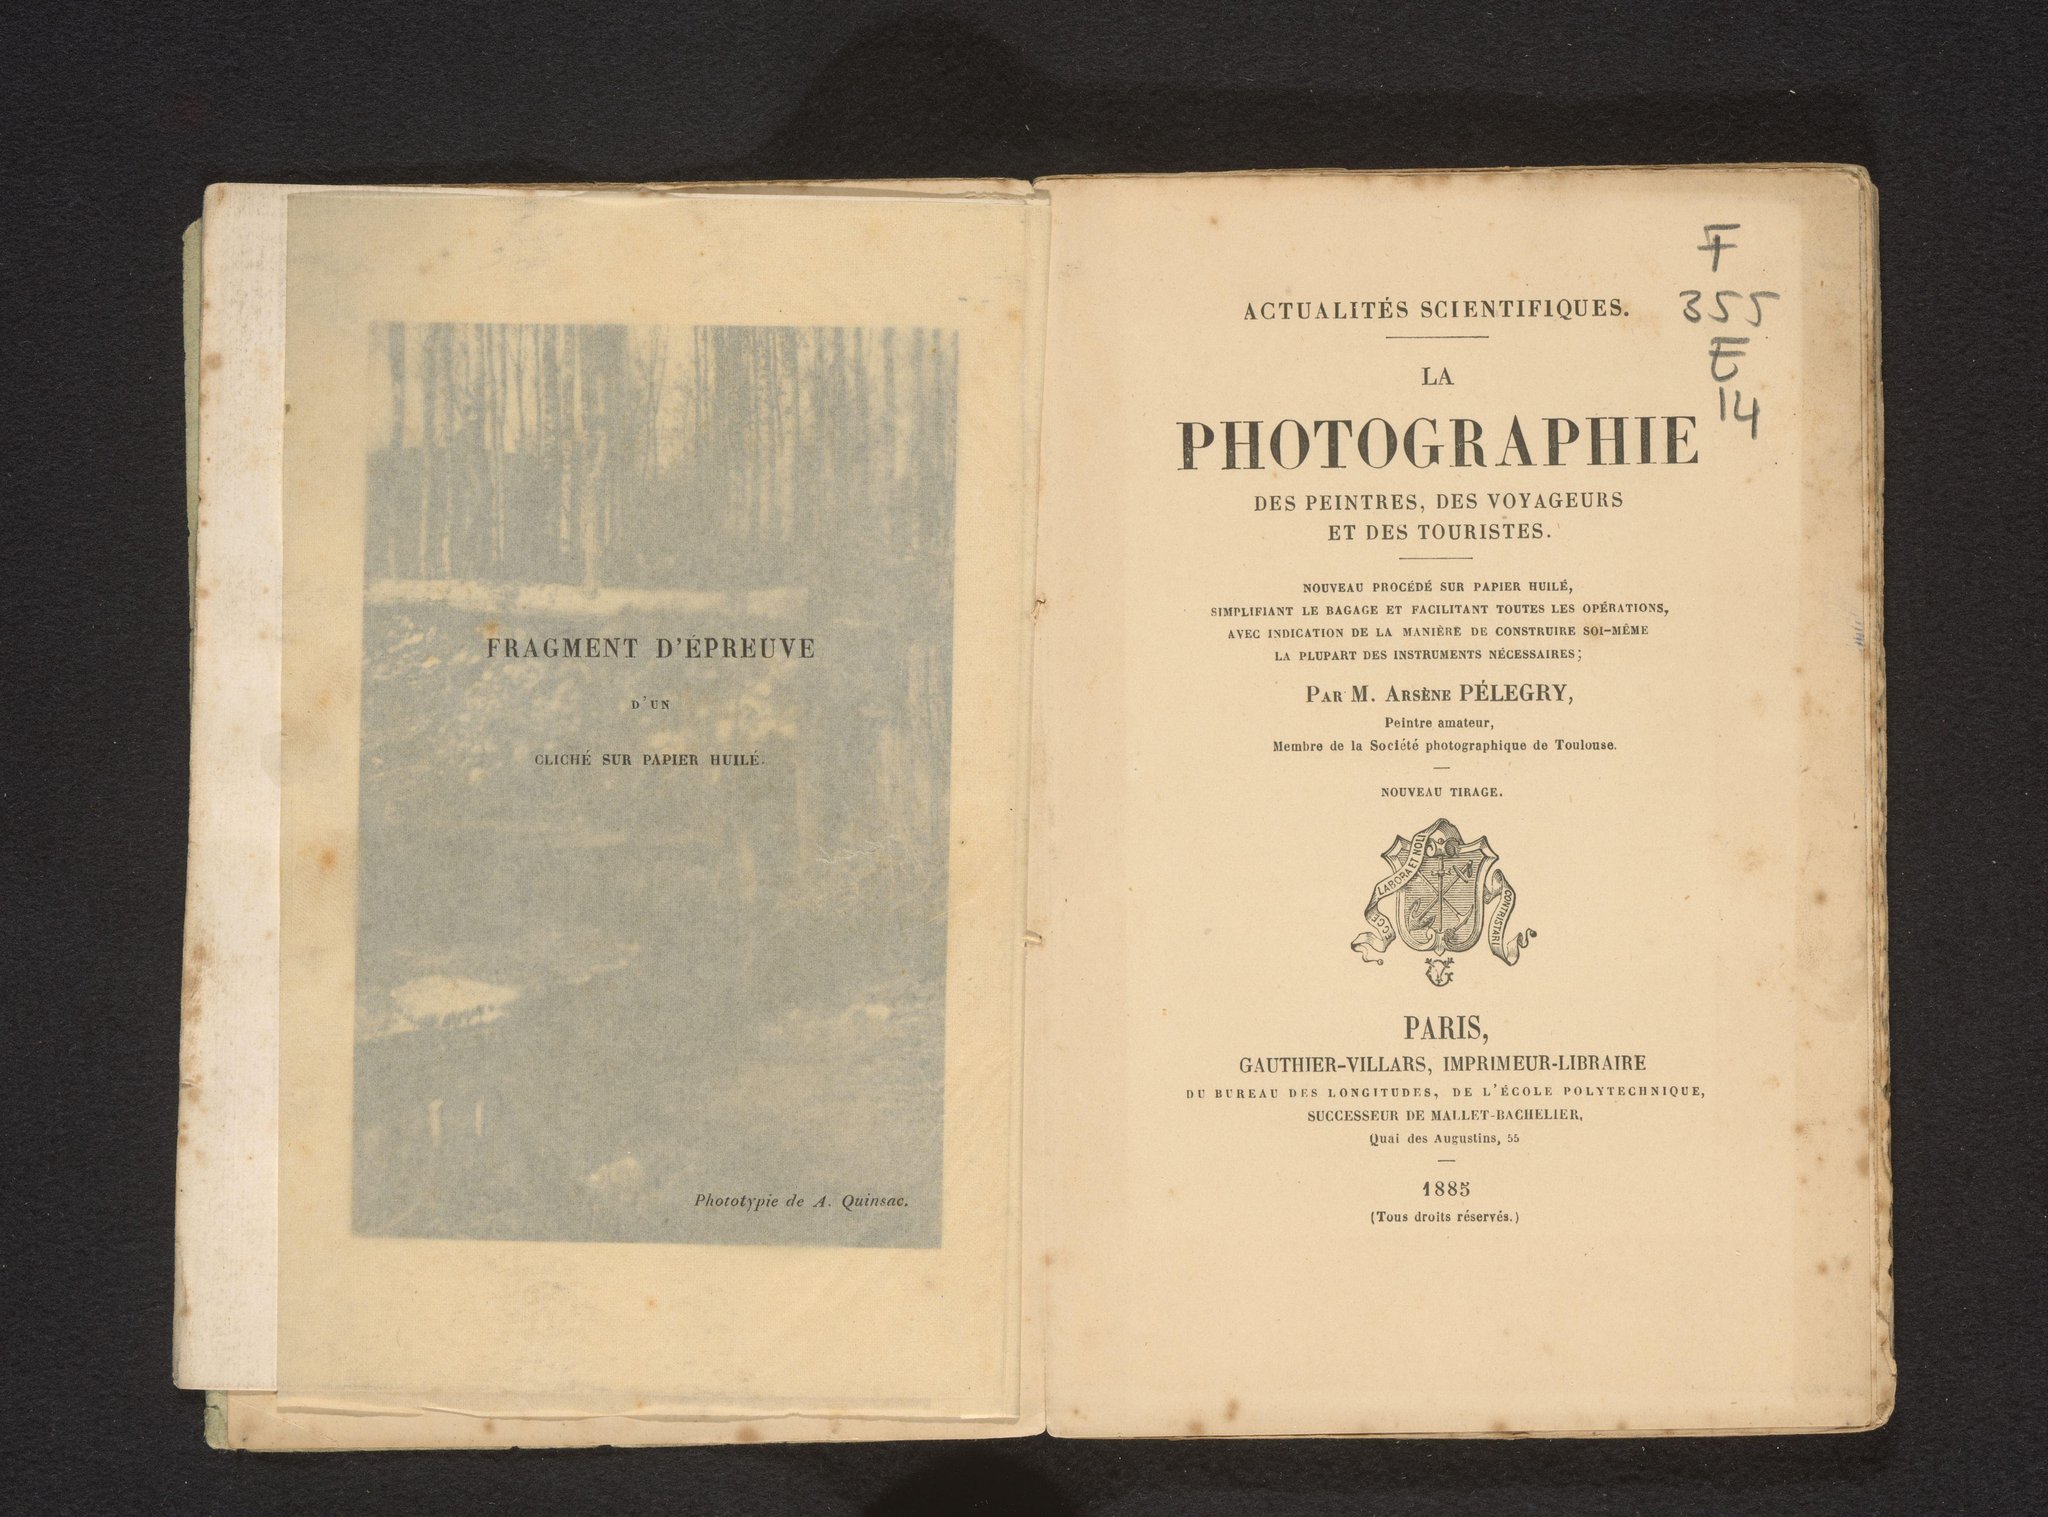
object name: book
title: La photographie des peintres, des voyageurs et des touristes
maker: eugène trutat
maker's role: fotograaf, geoloog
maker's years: 1840-1910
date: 1885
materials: cardboard, paper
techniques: photograph, printing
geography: paris